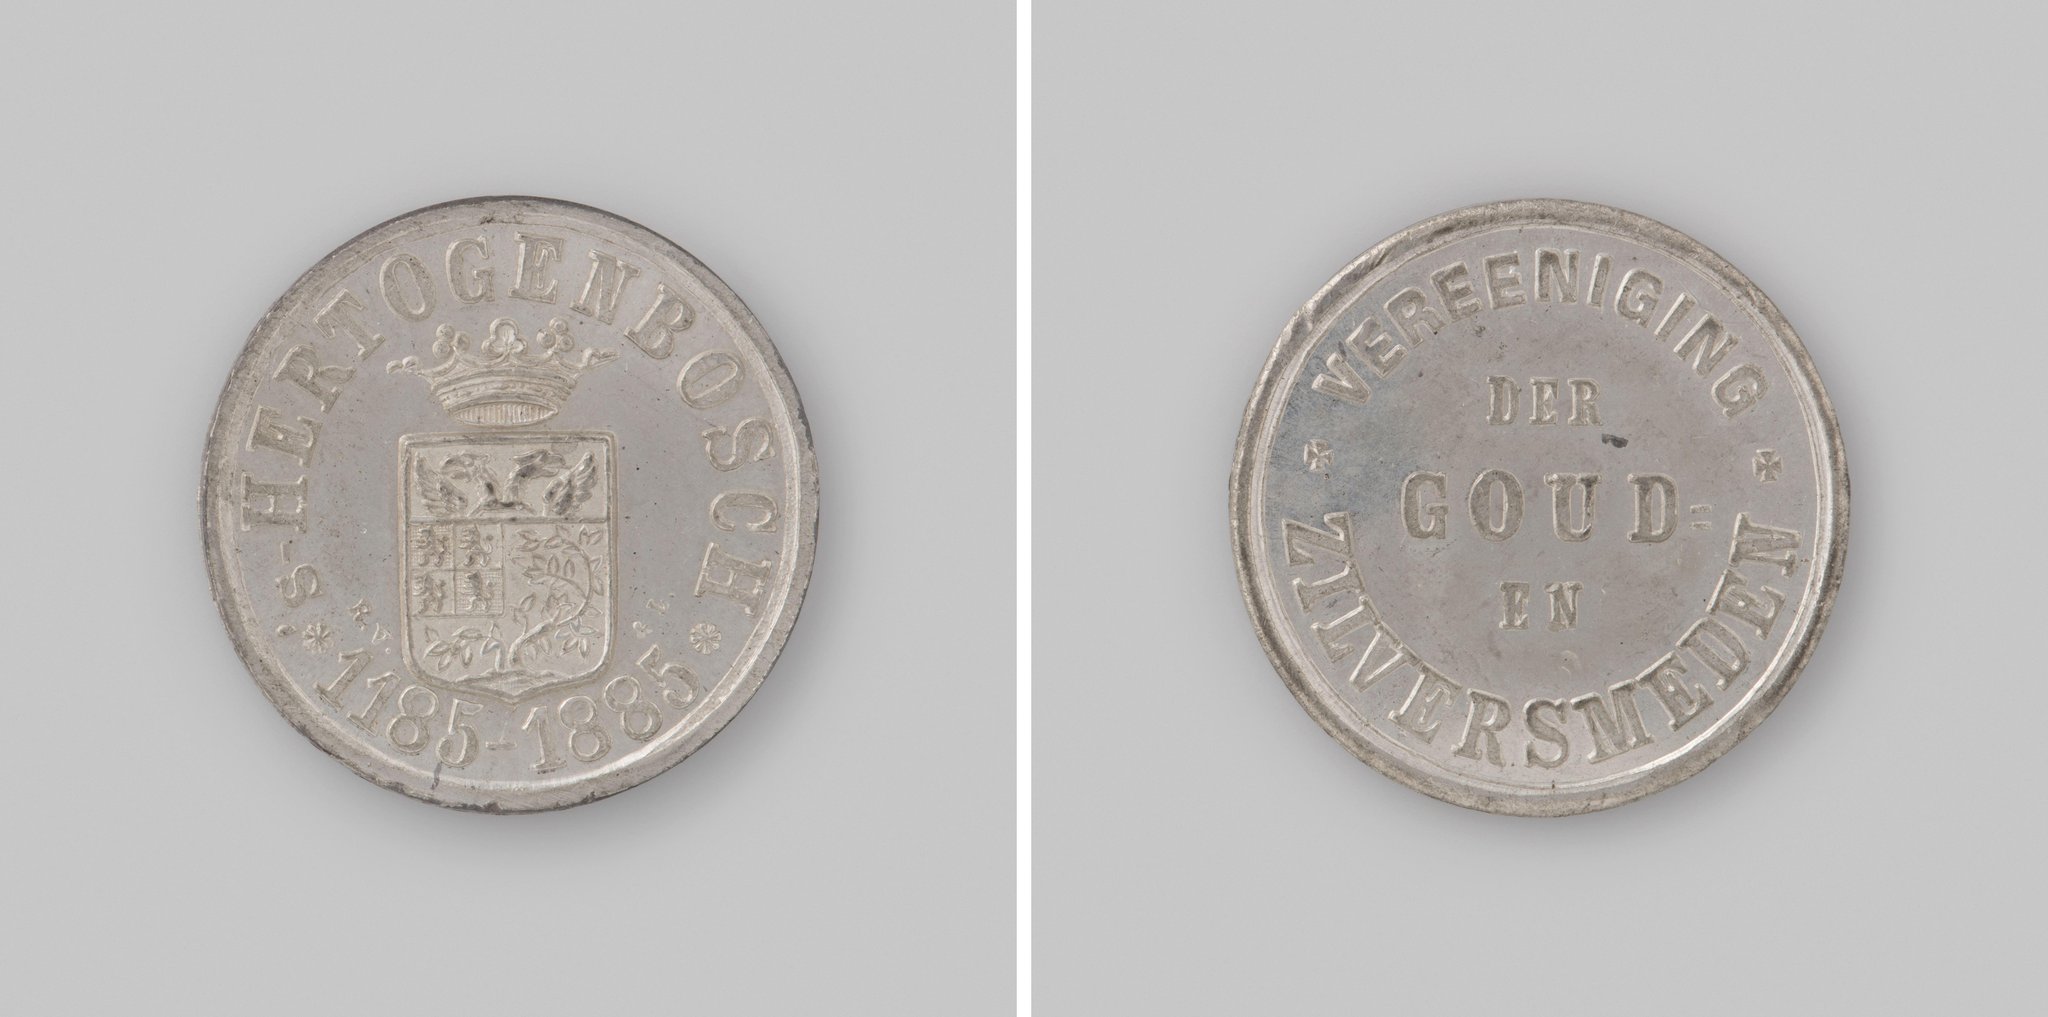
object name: history medal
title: Zevenhonderjarig bestaan van 's-Hertogenbosch herdacht door de Vereeniging van Goud- en Zilversmeden 1885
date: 1885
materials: tin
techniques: striking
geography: den bosch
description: Tinnen penning, op de voorzijde het gekroonde wapenschild van 's-Hertogenbosch met omschrift, op de keerzijde drie rekels tekst met omschrift.